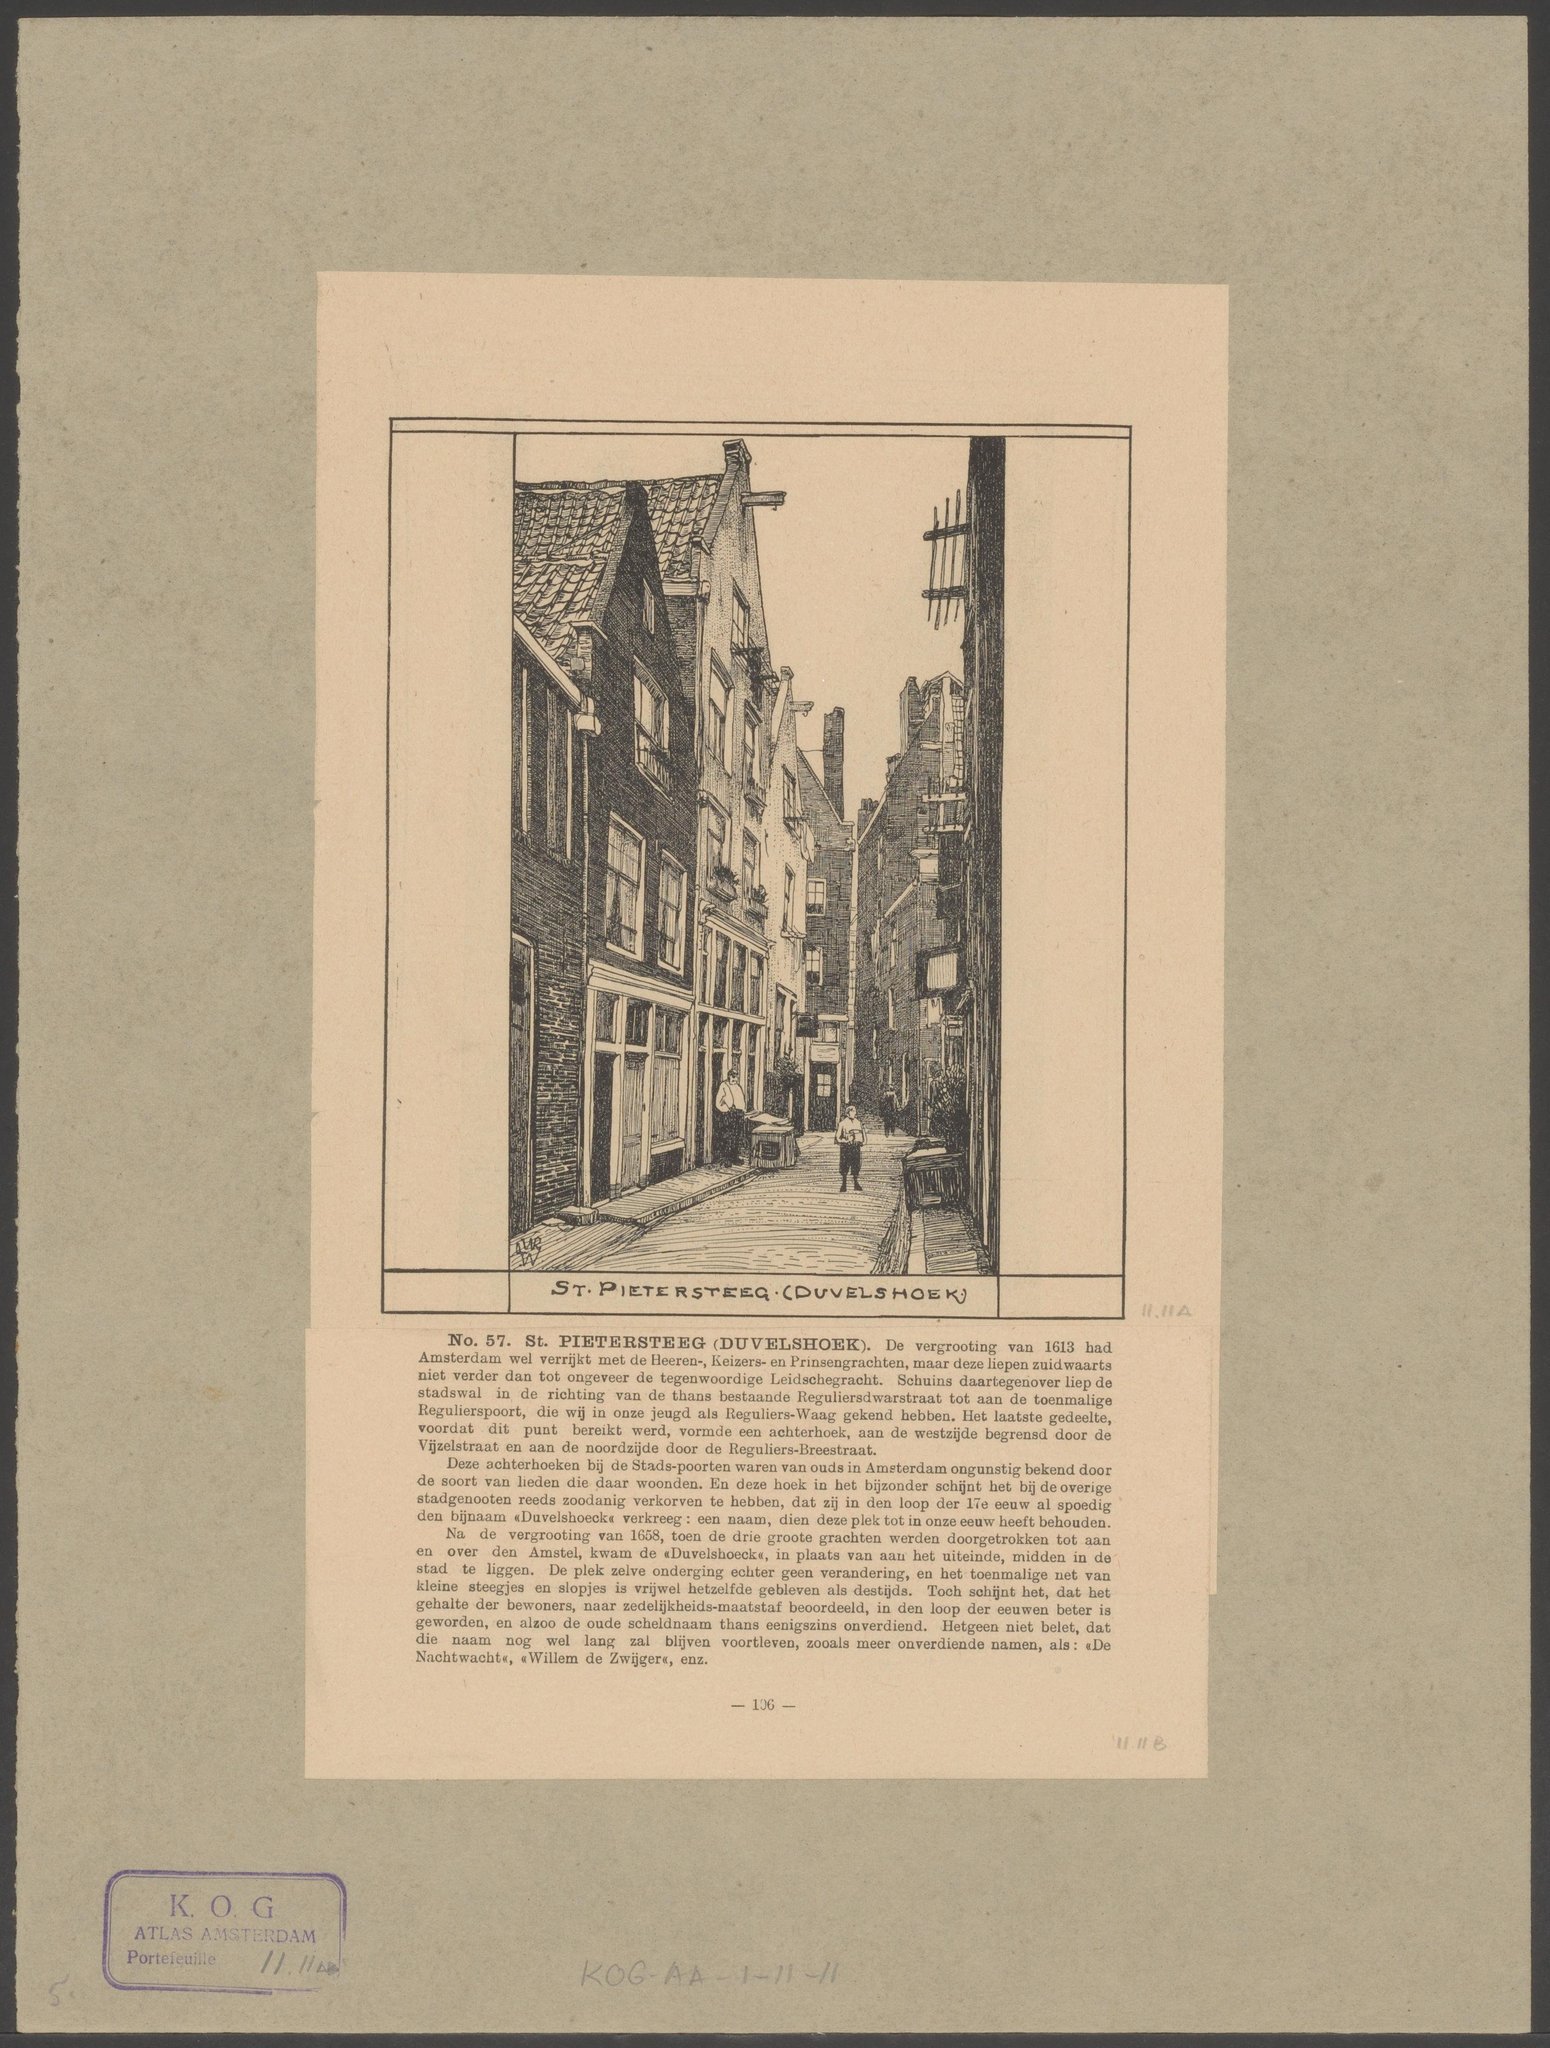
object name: photomechanical print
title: Oud-Amsterdam 100 Stadsgezichten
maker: willem wenckebach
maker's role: designer, draughtsman, painter, print maker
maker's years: 1860-1937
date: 1870-1923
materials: paper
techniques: letterpress printing, line block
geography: amsterdam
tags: city-view in general; 'veduta', the usual house or row of houses, lane, alley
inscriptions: collector's mark: ‘11.11AB’ Lugt 1641b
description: Onderwerpsrubriek binnen de Atlas Amsterdam: Paleisstraat, Palmgracht, Papenbrugsteeg, Passeerdersgracht, Peperstraat, Pieterspoort (St.), Pieterssteeg (St.), Plantage, Prinseneiland.